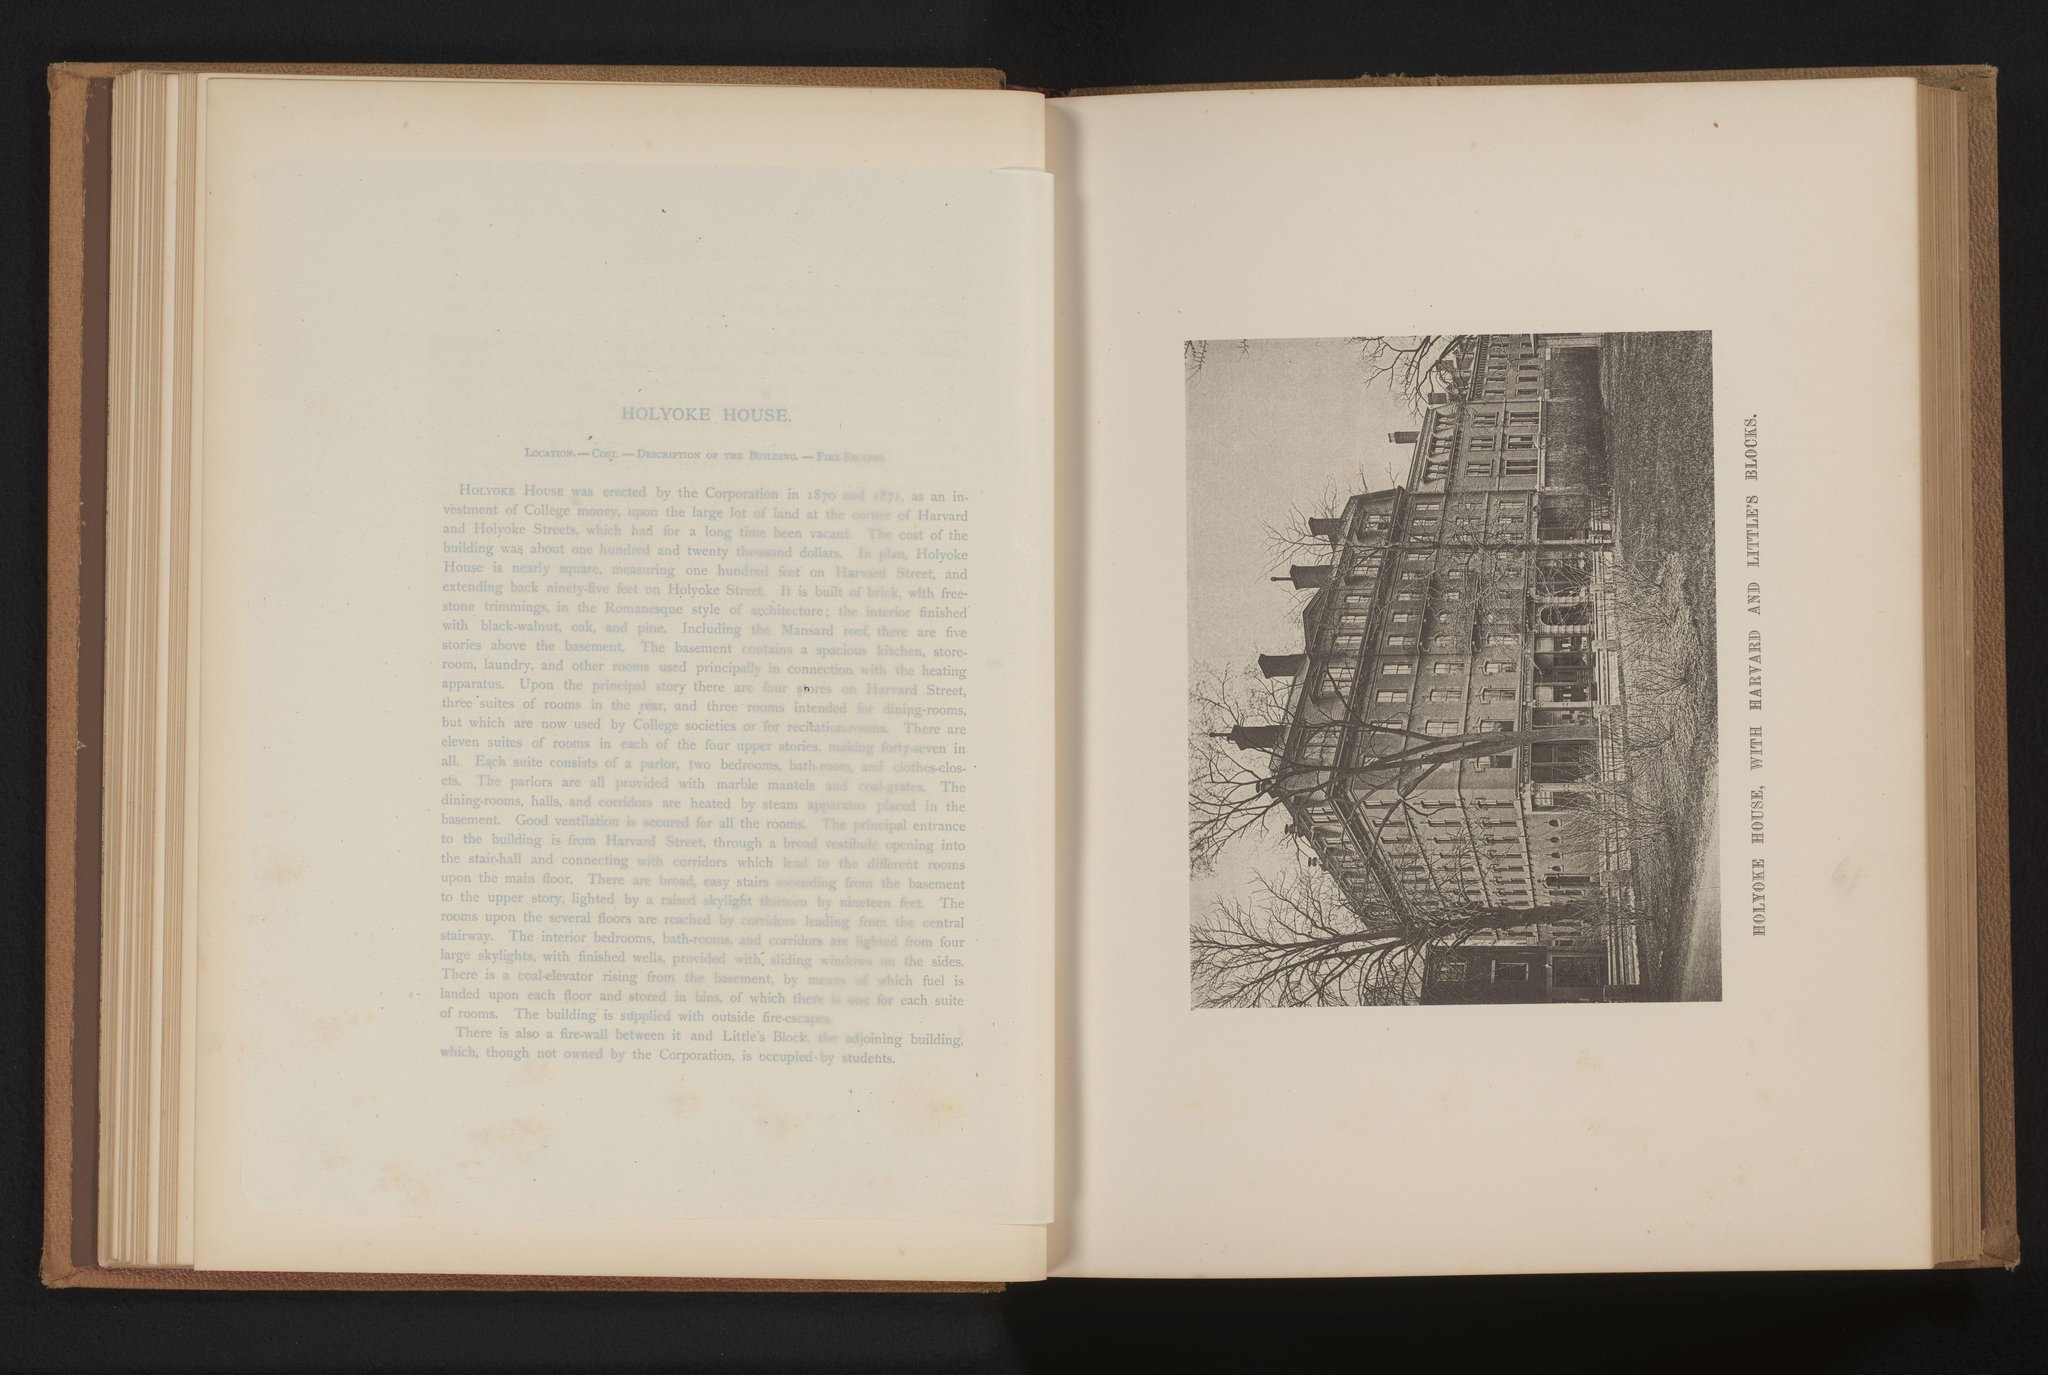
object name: page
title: Holyoke House, with Harvard and Littles blocks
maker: Anonymous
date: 1870-1875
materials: paper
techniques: photograph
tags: university building, college